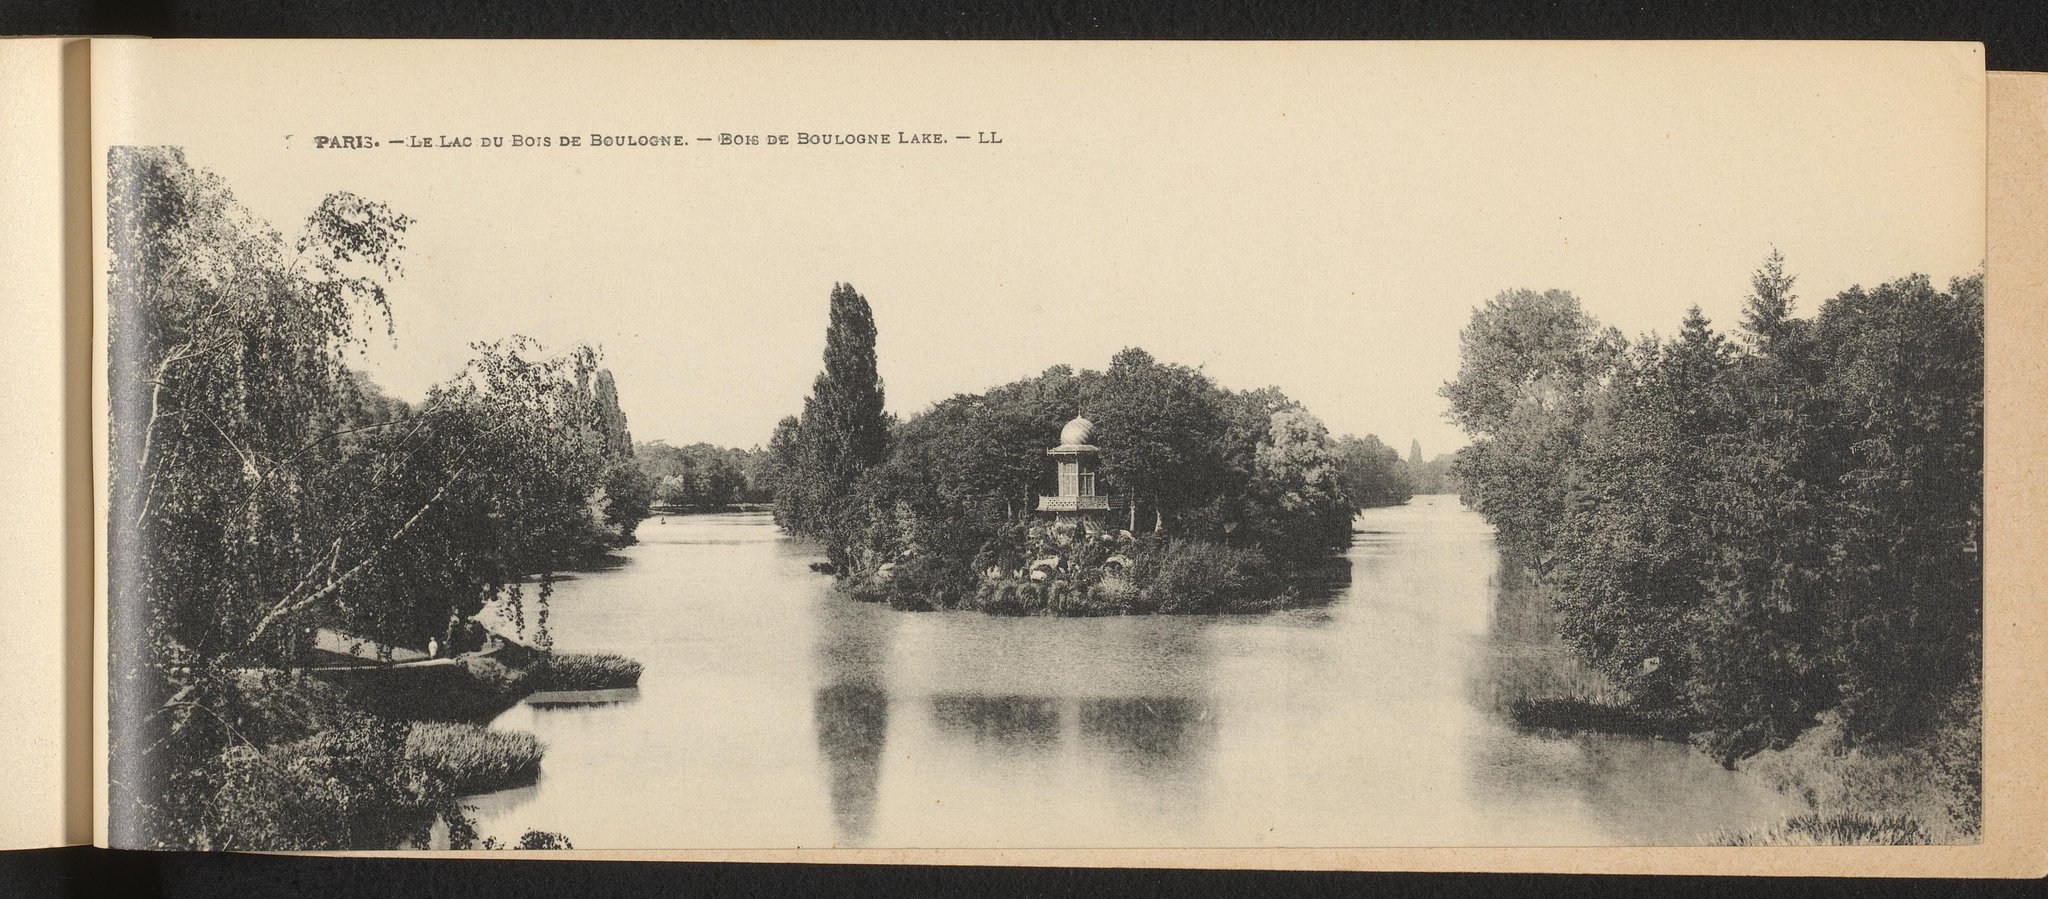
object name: photomechanical print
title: Paris. Le Lac du Bois de Boulogne / Bois de Boulogne Lake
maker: Anonymous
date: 1920-1932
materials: cardboard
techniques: photograph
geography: paris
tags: lake, public gardens, park